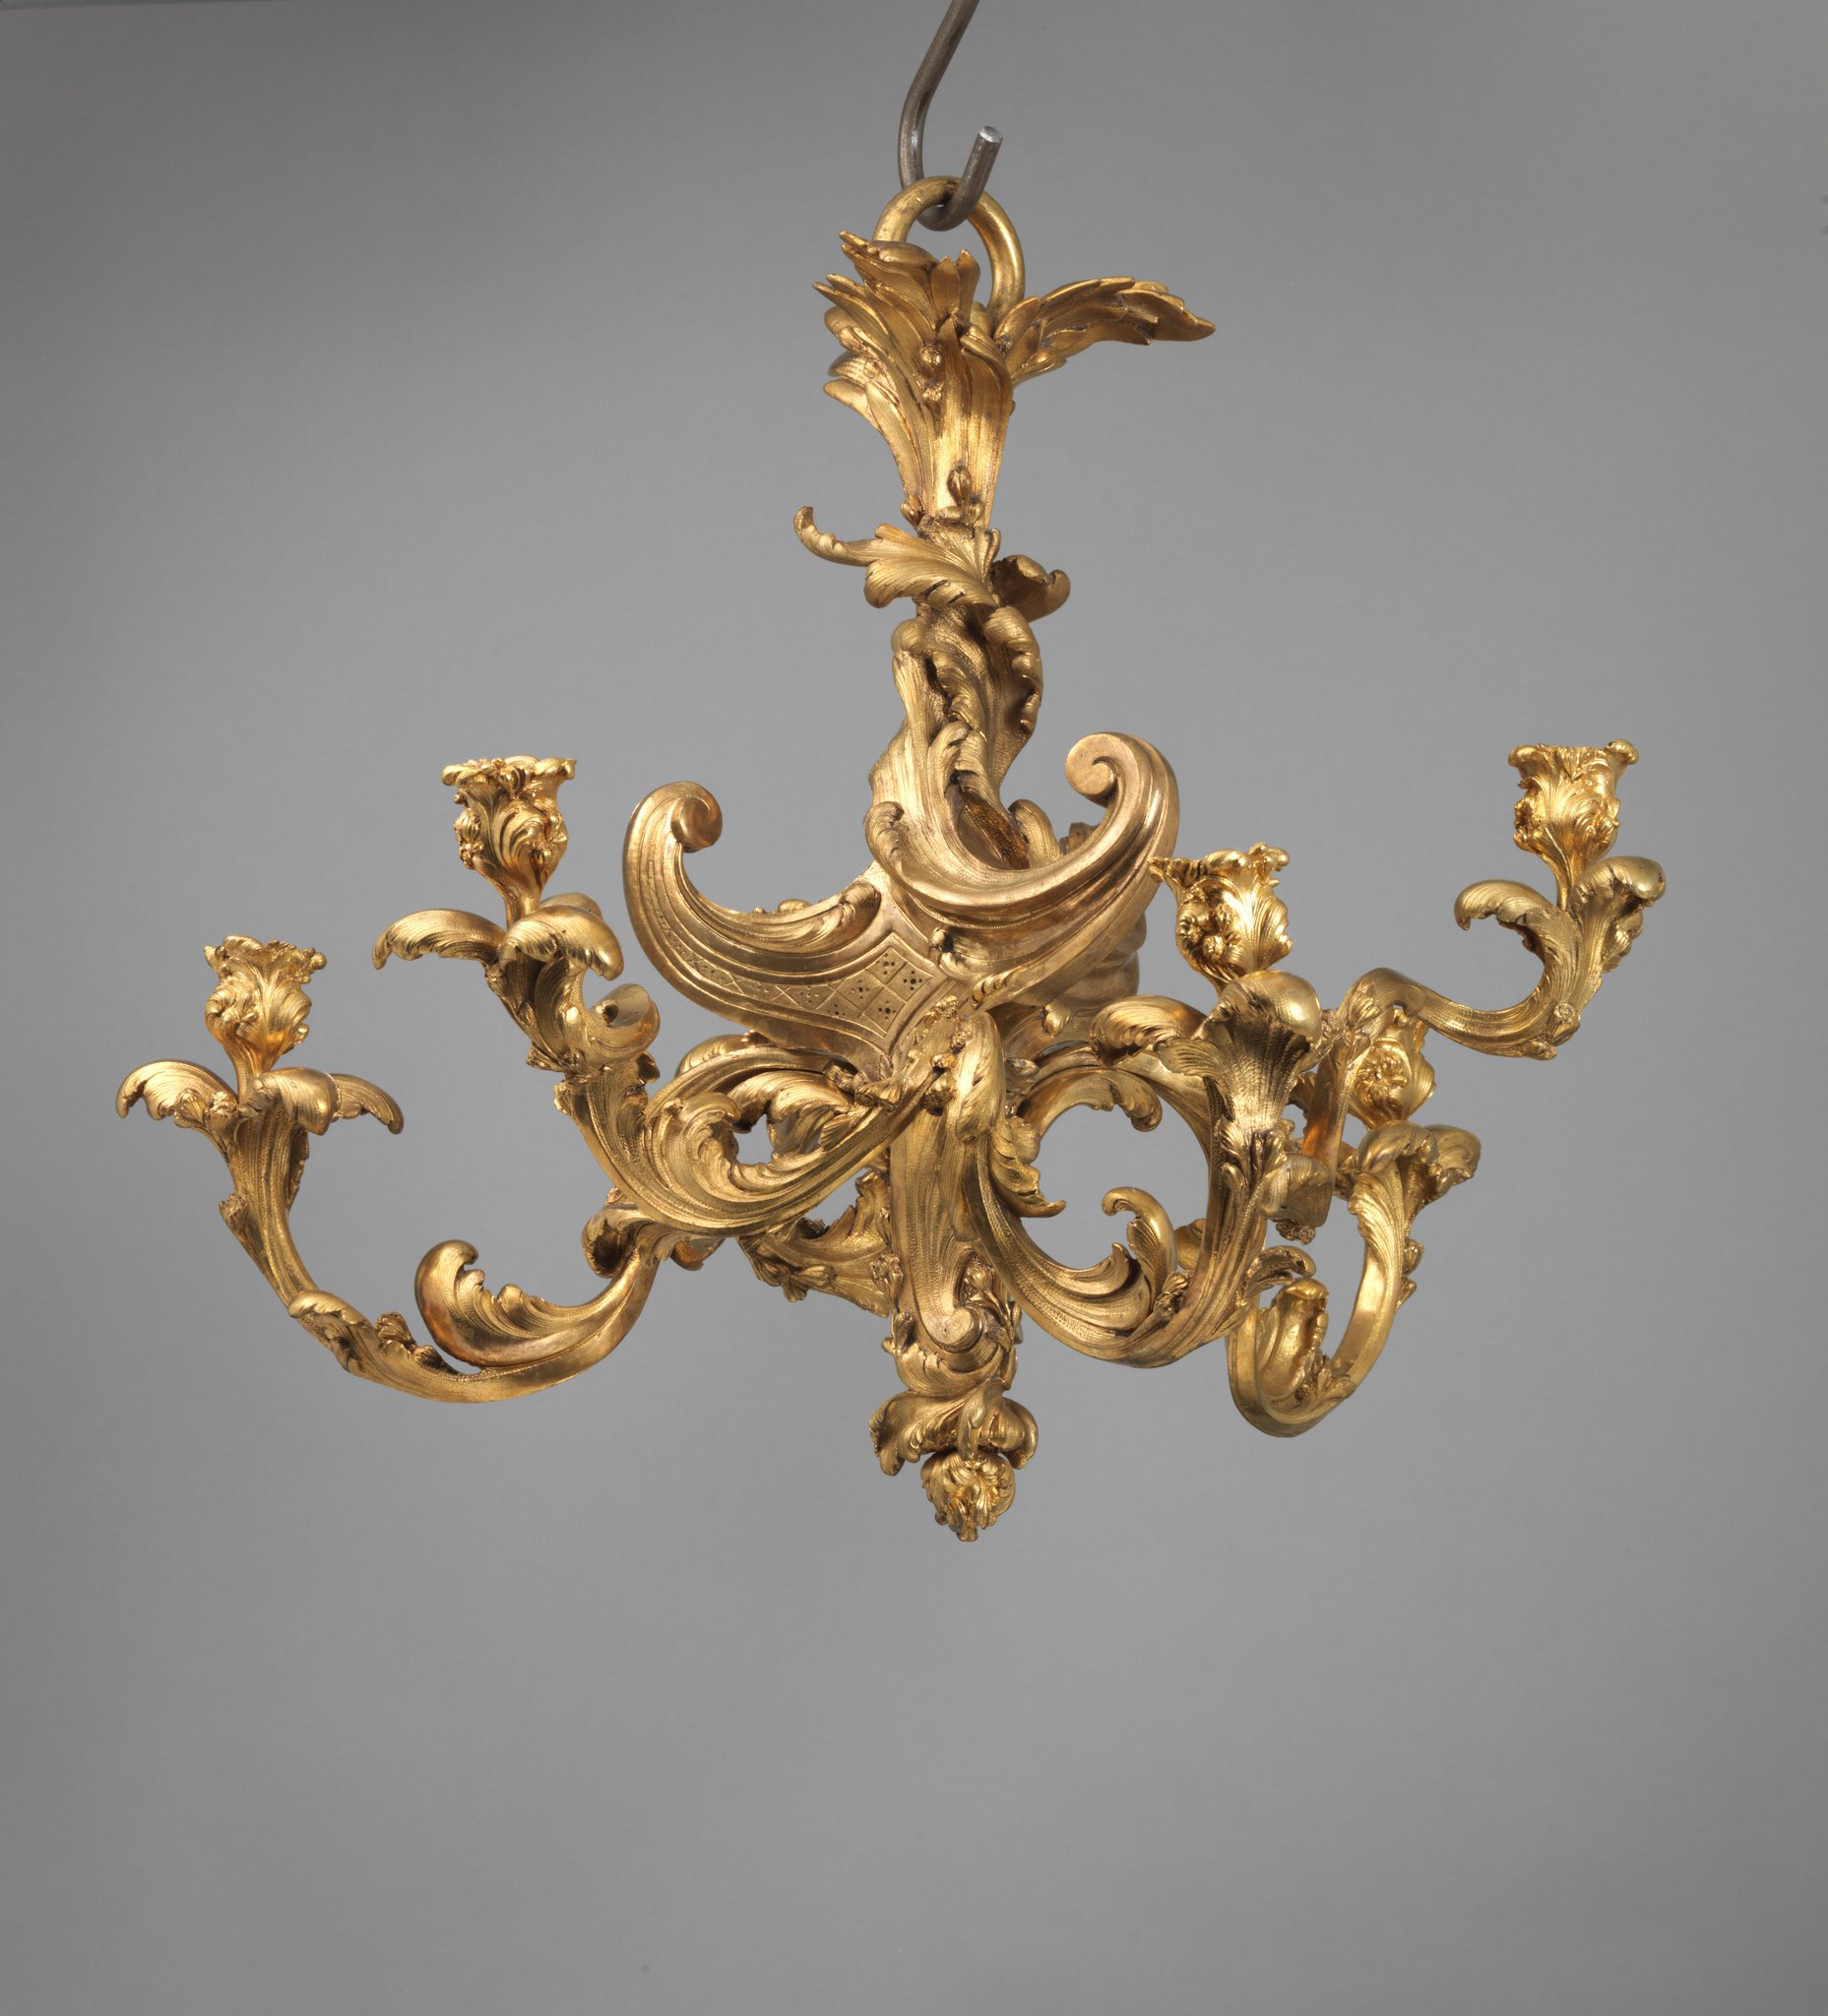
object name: chandelier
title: Six-light chandelier (one of a pair)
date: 1740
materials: gilt bronze